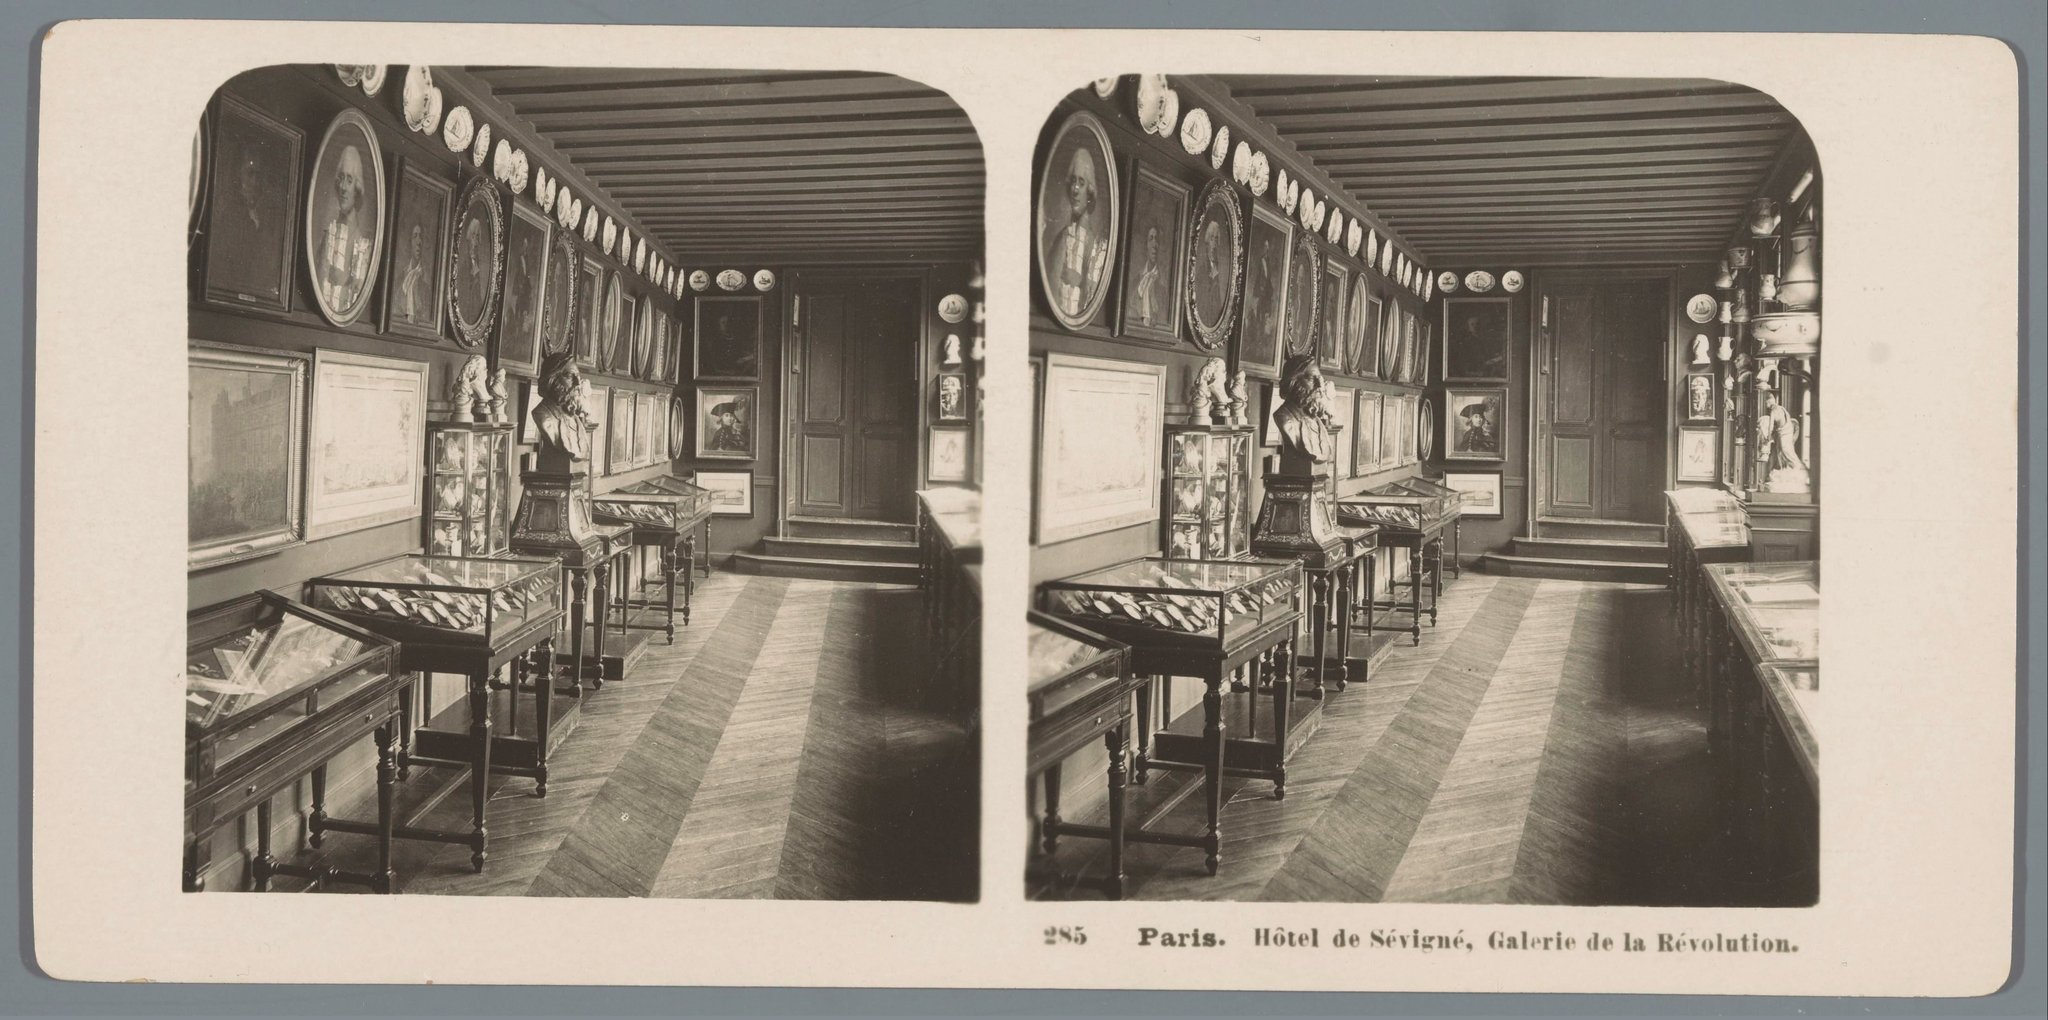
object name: stereograph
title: Interieur van de Galerie de la Révolution in het Hôtel de Sévigné te Parijs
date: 1904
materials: cardboard, photographic support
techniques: gelatin silver print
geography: paris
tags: art collection, art gallery, hôtel, i.e. small palace in city - aa - civic architecture: inside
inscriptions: inscription: ‘Neue Photographische Gesellschaft A.-G. Steglitz-Berlin 1904.’, number: ‘285’